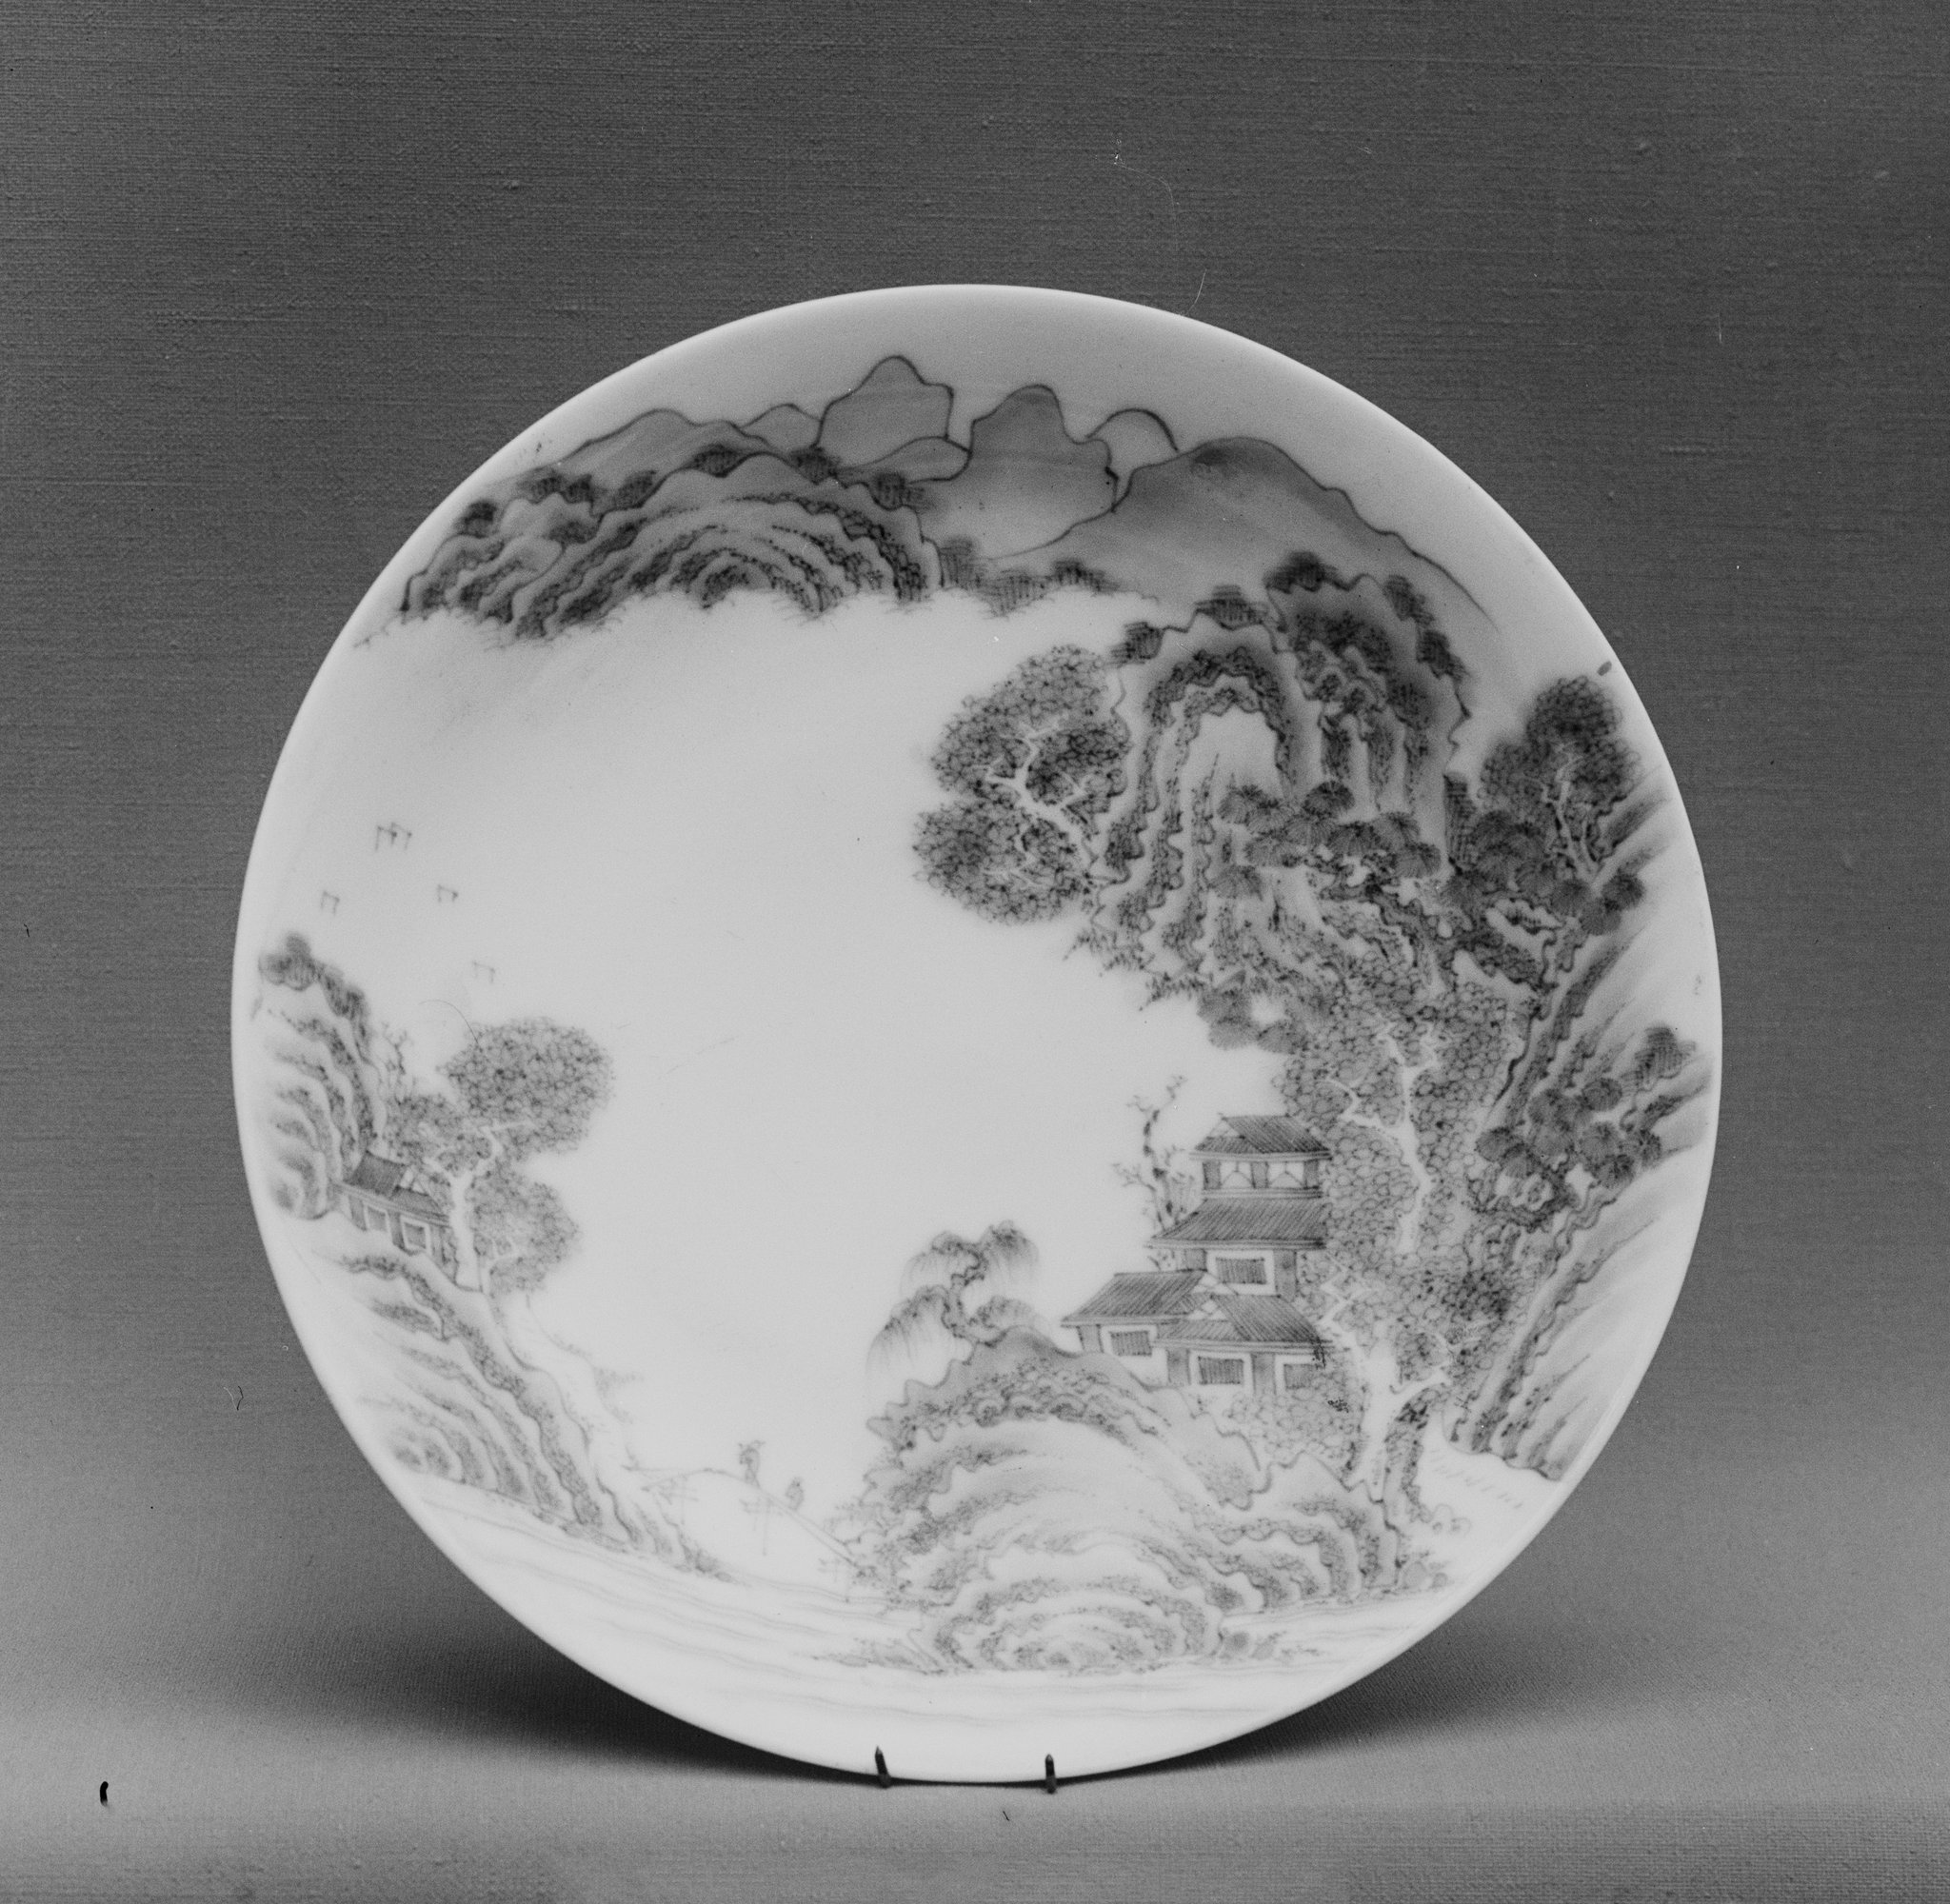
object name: saucer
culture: japanese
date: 1780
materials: glaze, porcelain